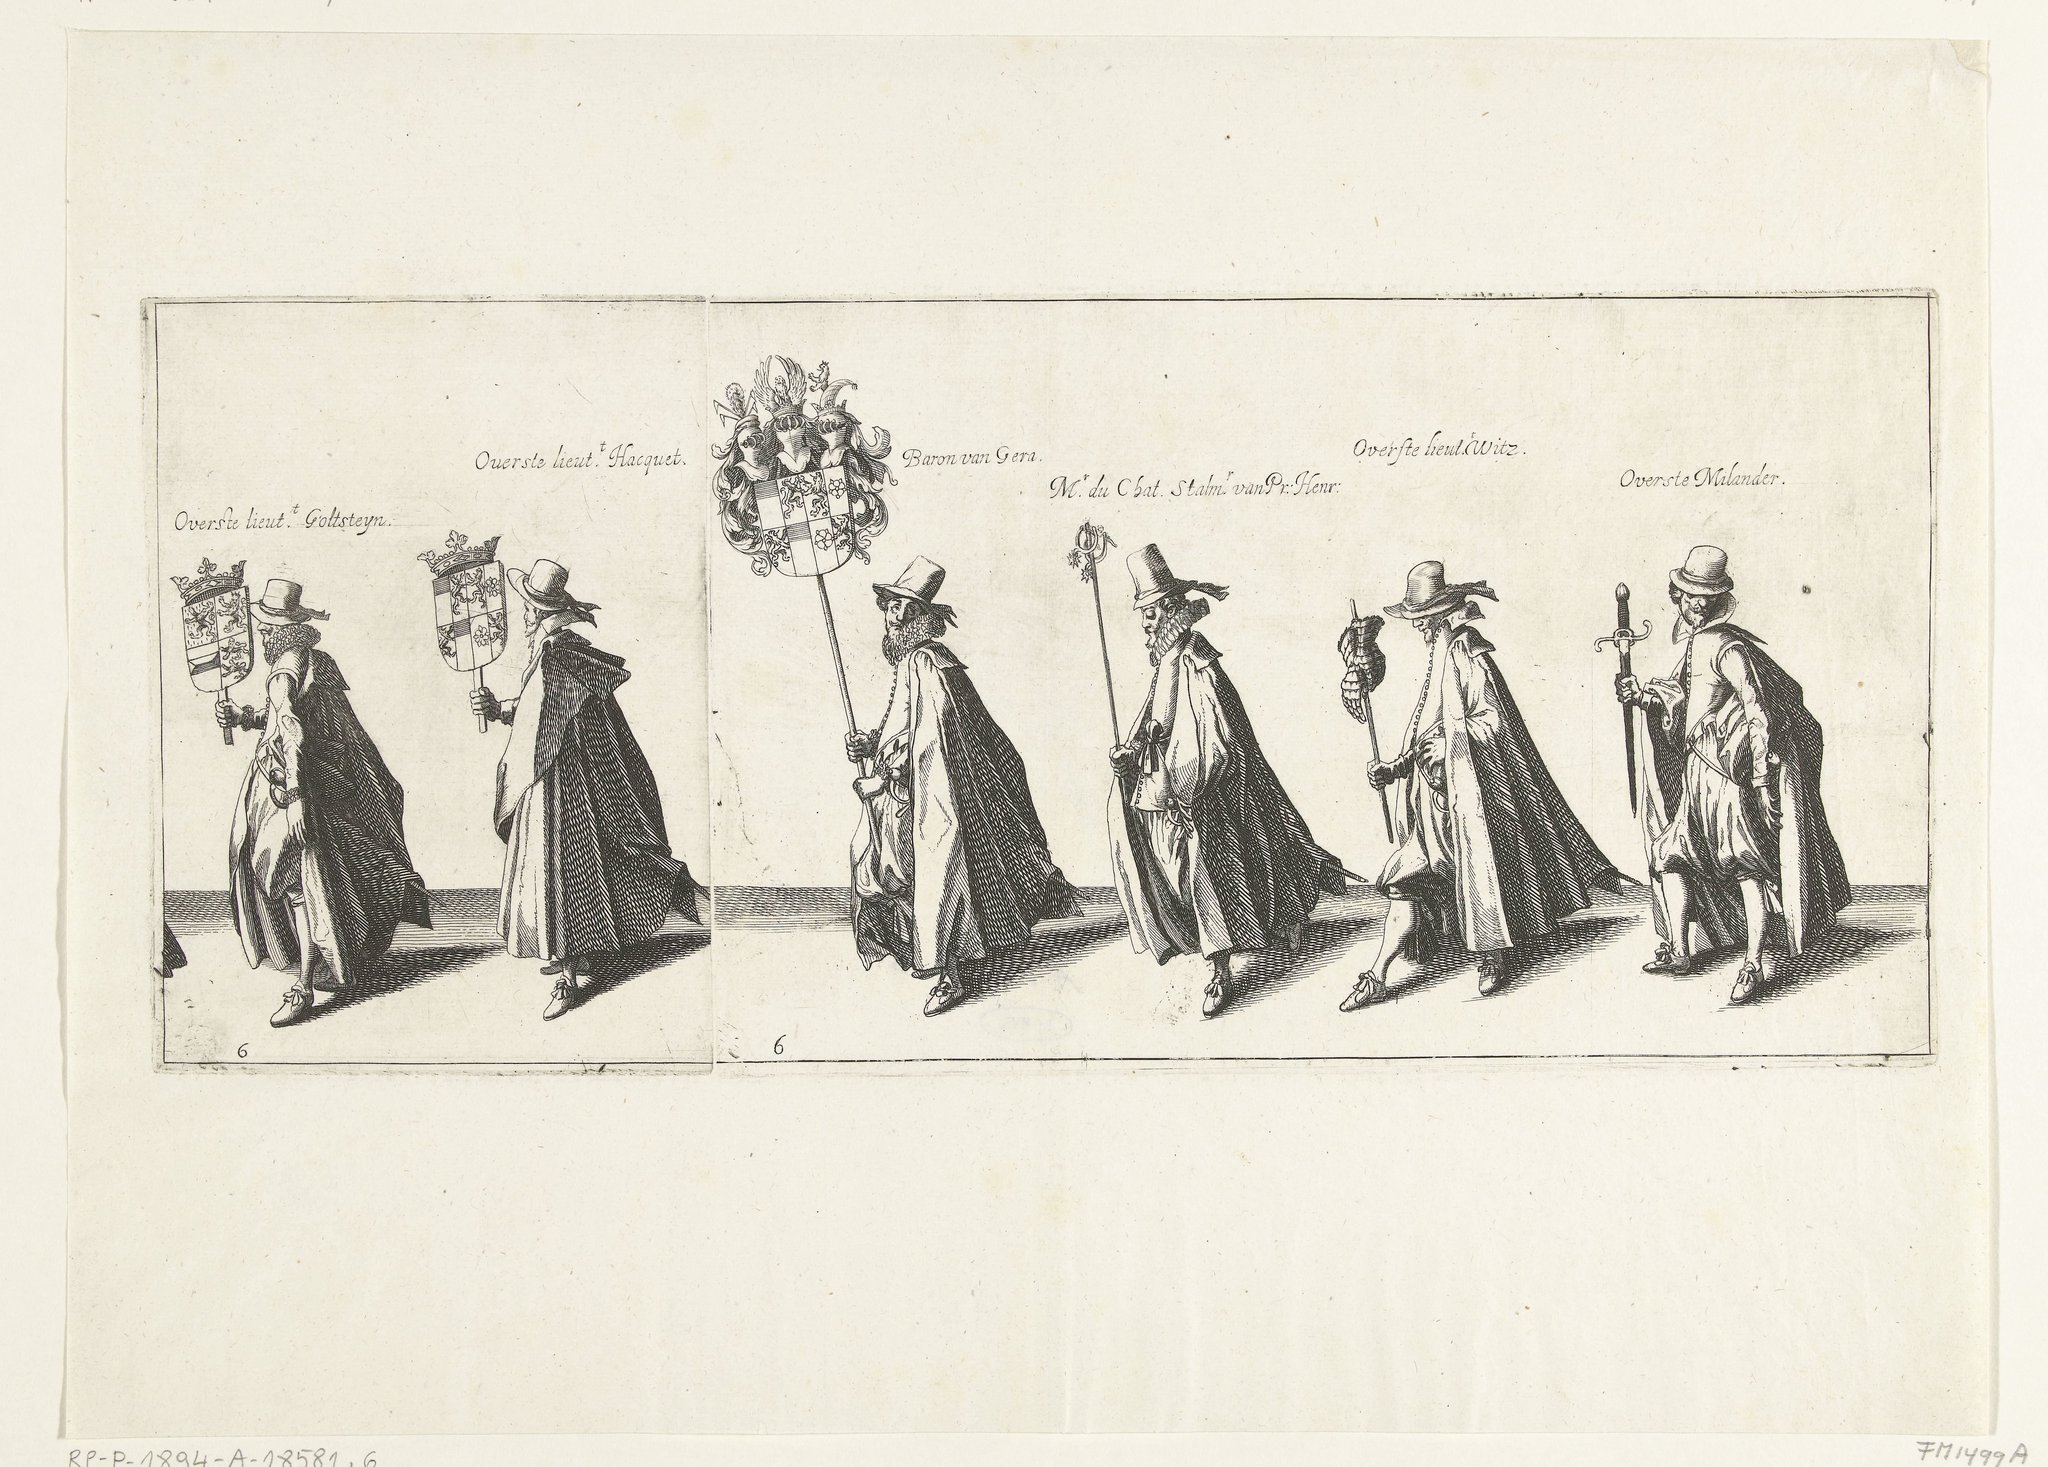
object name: print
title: Begrafenis van Johann Albrecht, graaf van Solms, 1623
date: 1615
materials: paper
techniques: etching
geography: northern netherlands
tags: cortege, funeral procession, the hague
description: De begrafenisstoet (plaat 6). Deelnemers met onderdelen van de wapenrusting. Gedrukt van twee platen. Onderdeel van de serie prenten van de begrafenisoptocht van Johann Albrecht, graaf van Solms, op 25 mei 1623 te Den Haag.